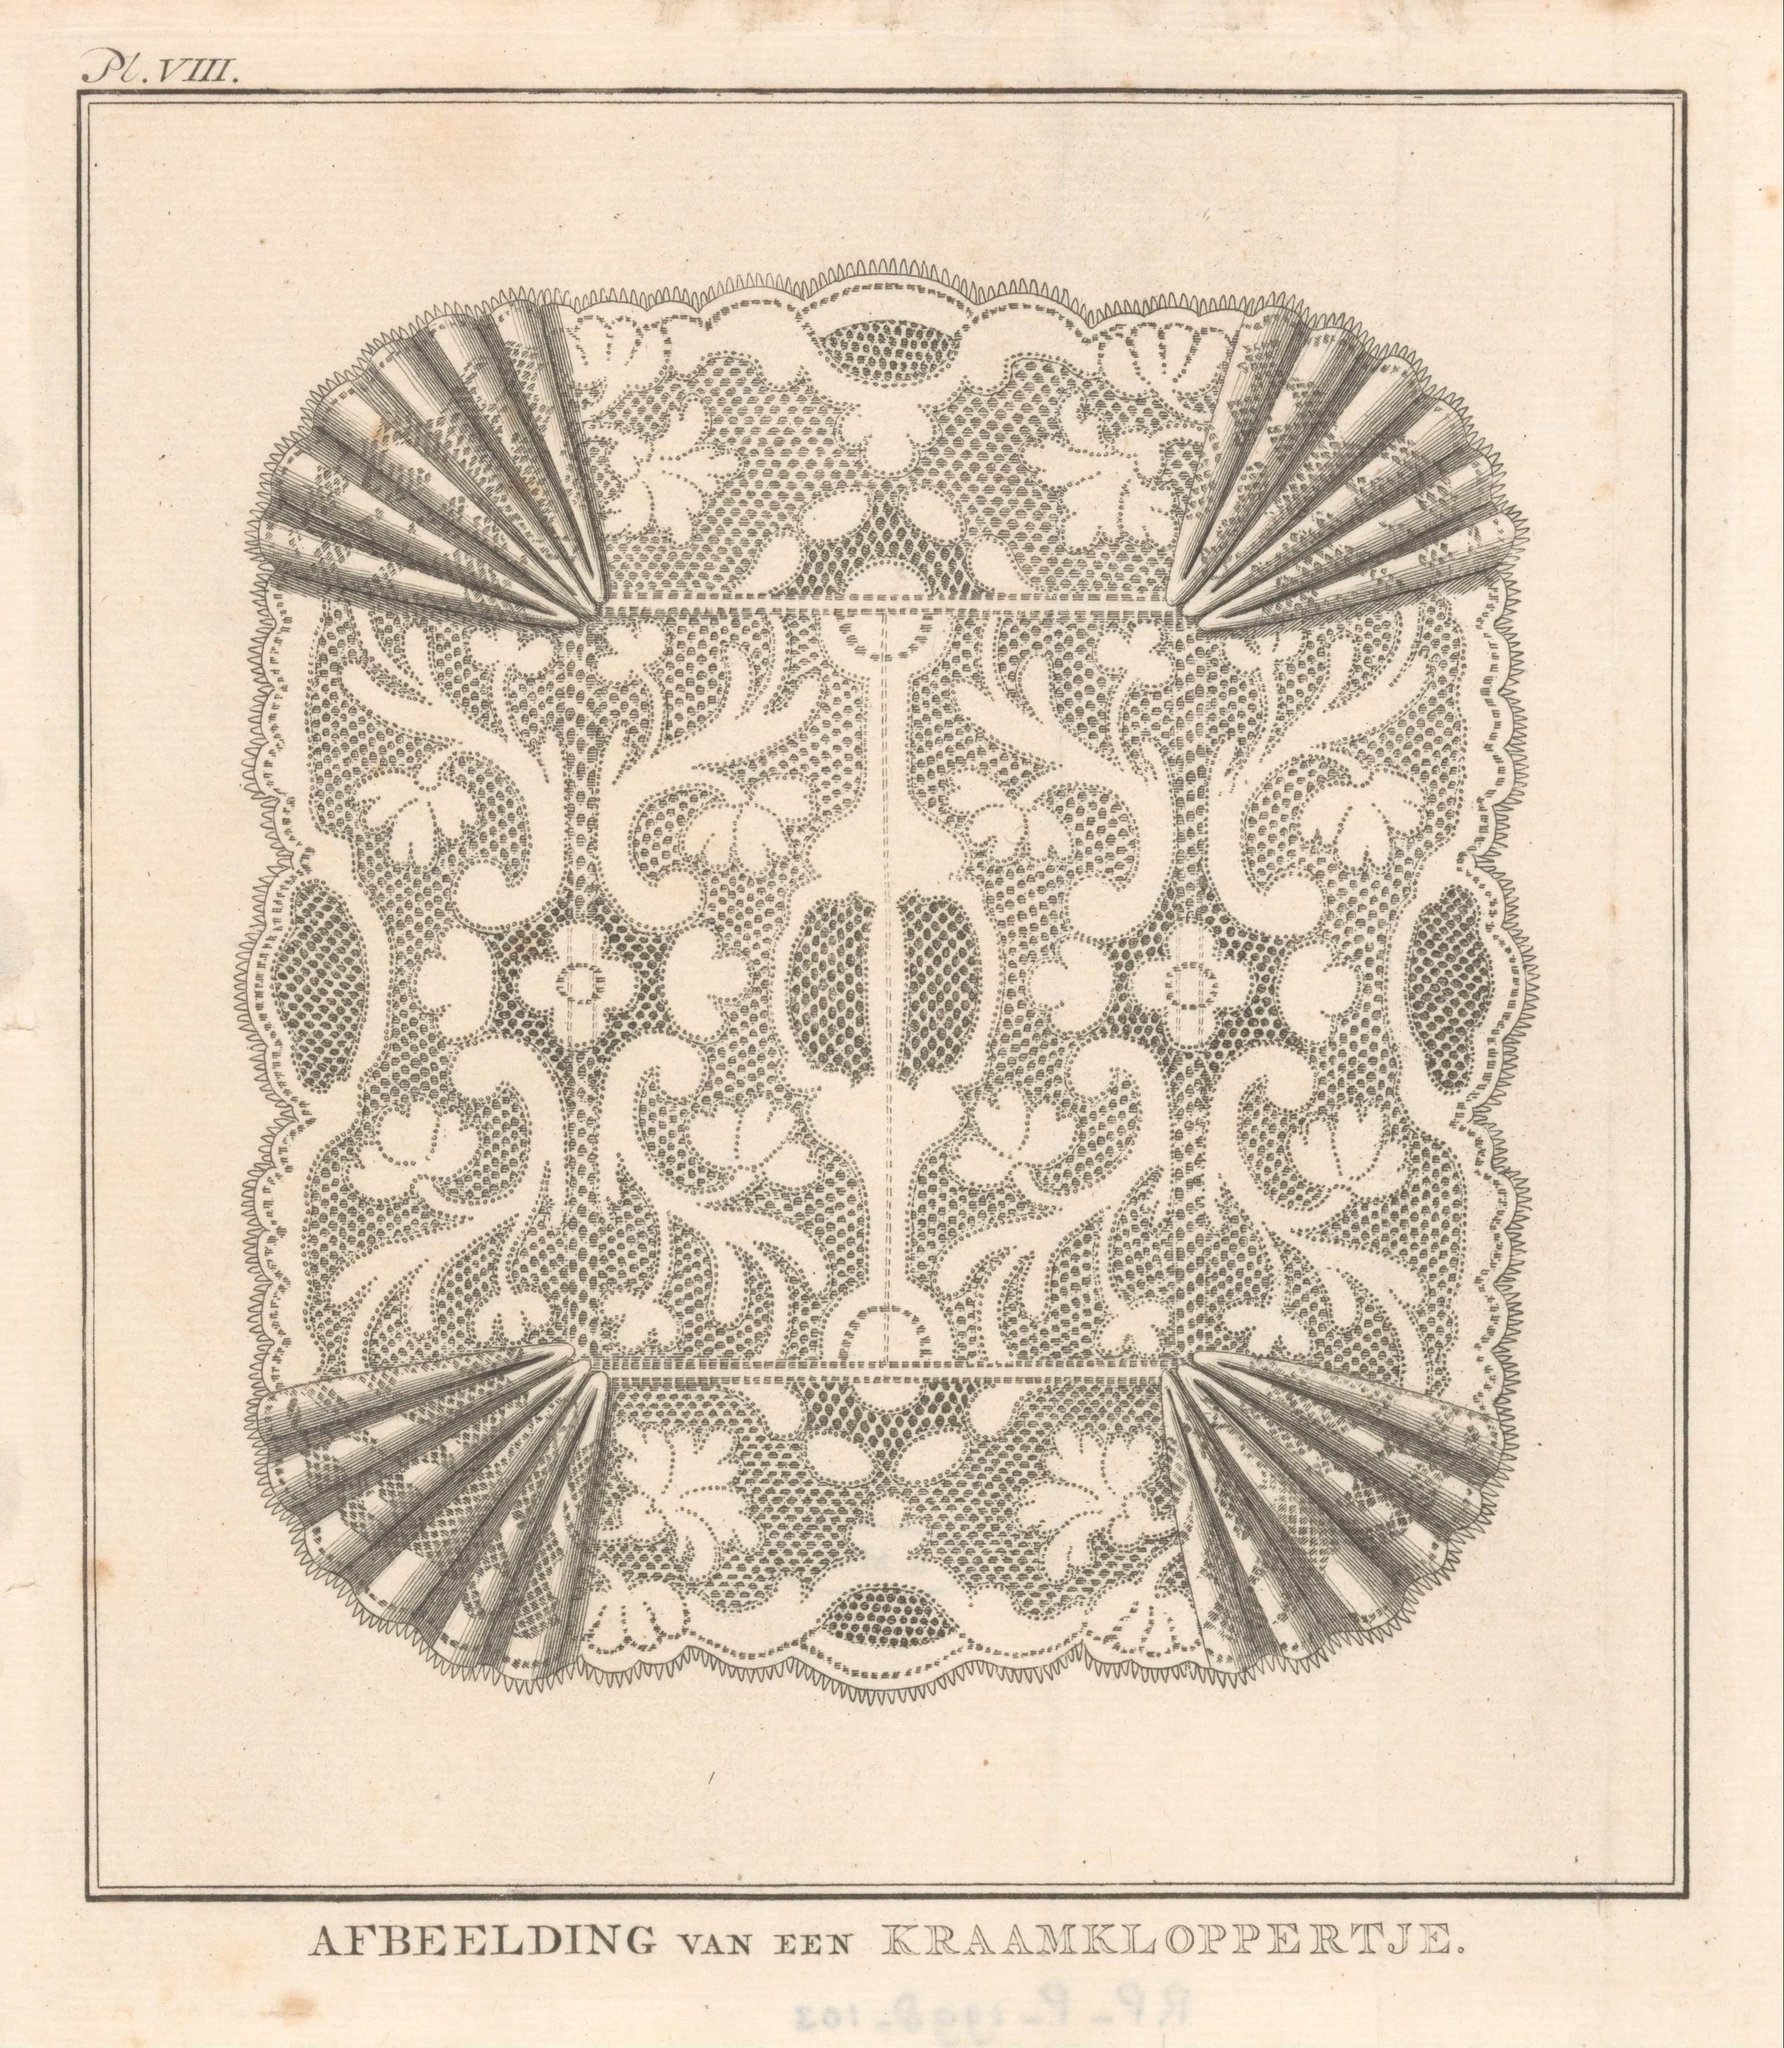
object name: print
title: Afbeelding van een Kraamkloppertje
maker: Anonymous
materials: paper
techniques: etching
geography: amsterdam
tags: door-knocker, doorbell, tokens to denote the house of a woman in child-bed, lace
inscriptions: collector's mark: Lugt 2228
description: Een kanten kraamklopper. Gebruikt circa 1750 in Haarlem om onder de deurklopper aan de deur te hangen om het geluid van de klopper te verzachten en om aan te geven dat er een kind in het huis was geboren. Links boven: Pl. VIII.